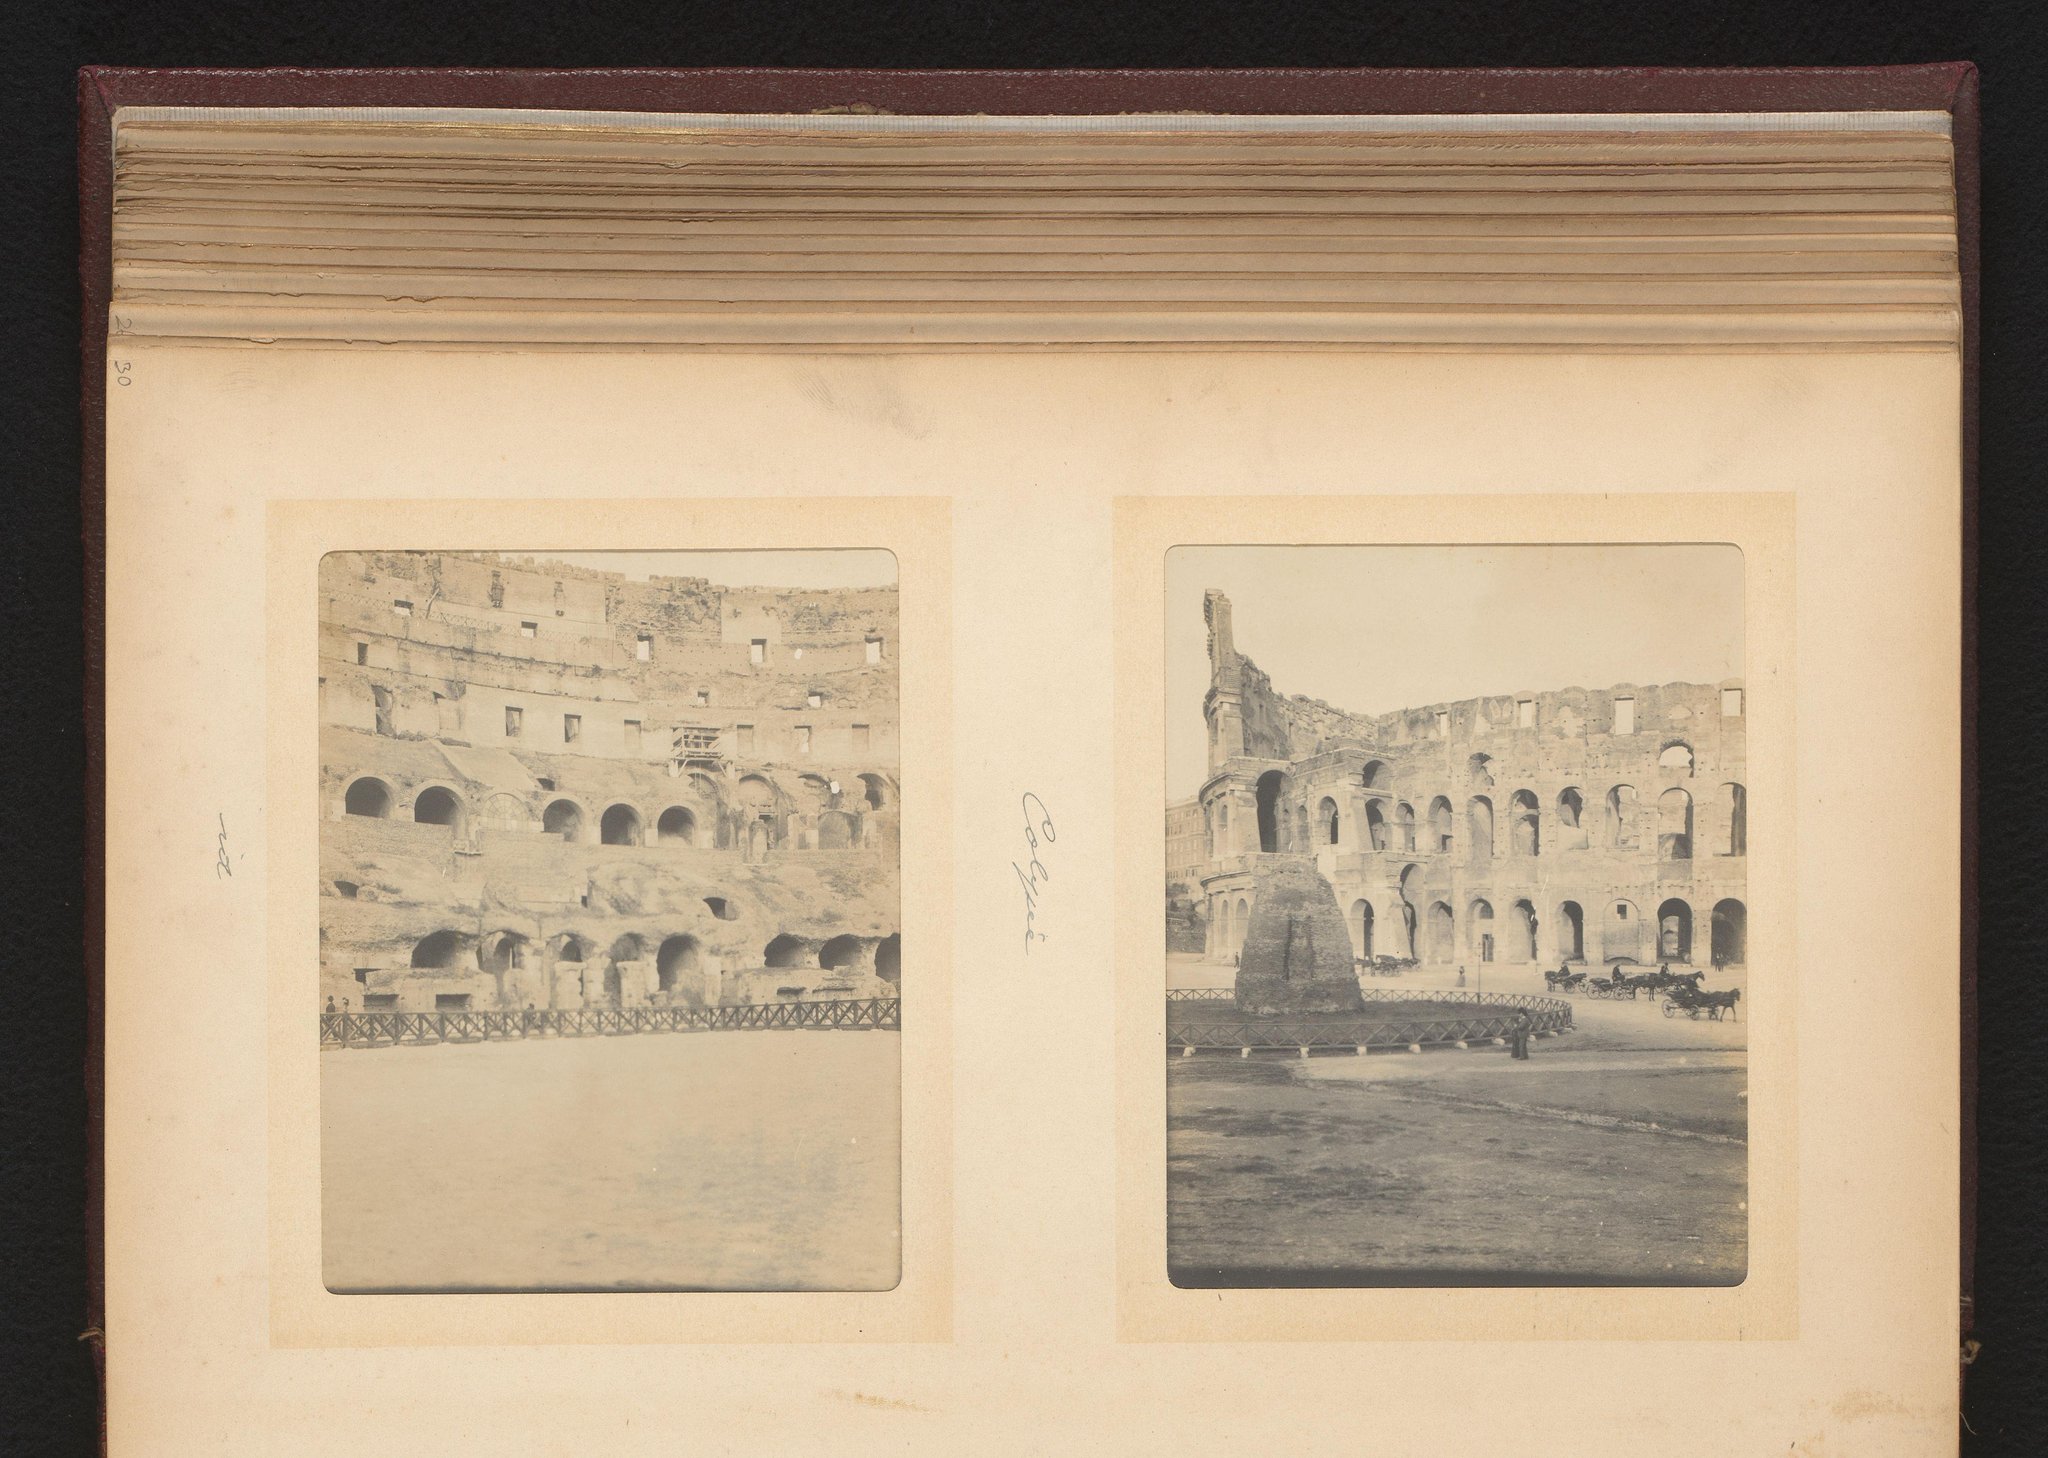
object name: album leaf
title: Het Colosseum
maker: Anonymous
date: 1895-1905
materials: cardboard, photographic support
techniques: gelatin silver print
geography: rome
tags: tourism, ruin of a building ~ architecture, amphitheatre, rome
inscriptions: inscription: ‘Colysée / id.’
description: Albumblad met twee foto's in Rome. Onderdeel van een fotoalbum van een reis door Italië, ca. 1900.